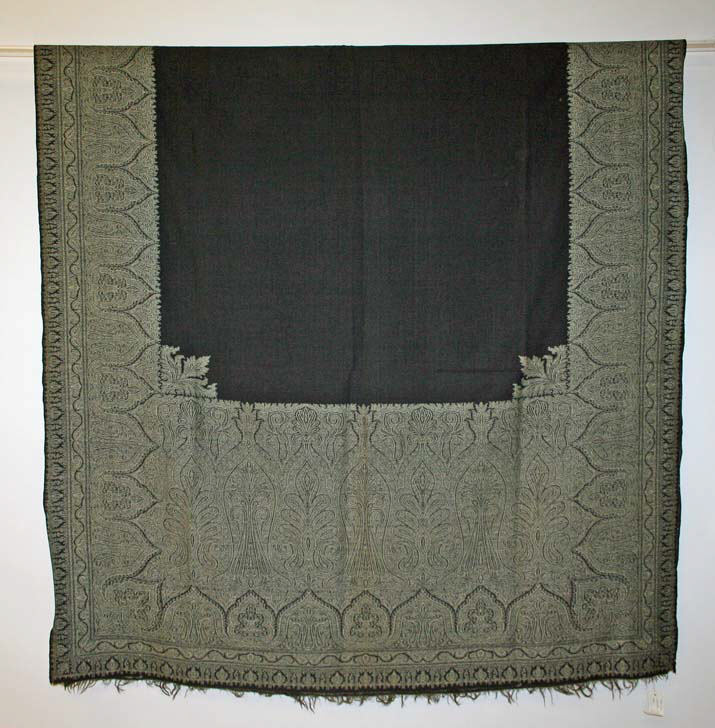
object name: mourning shawl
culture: british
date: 1840-1850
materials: silk, wool